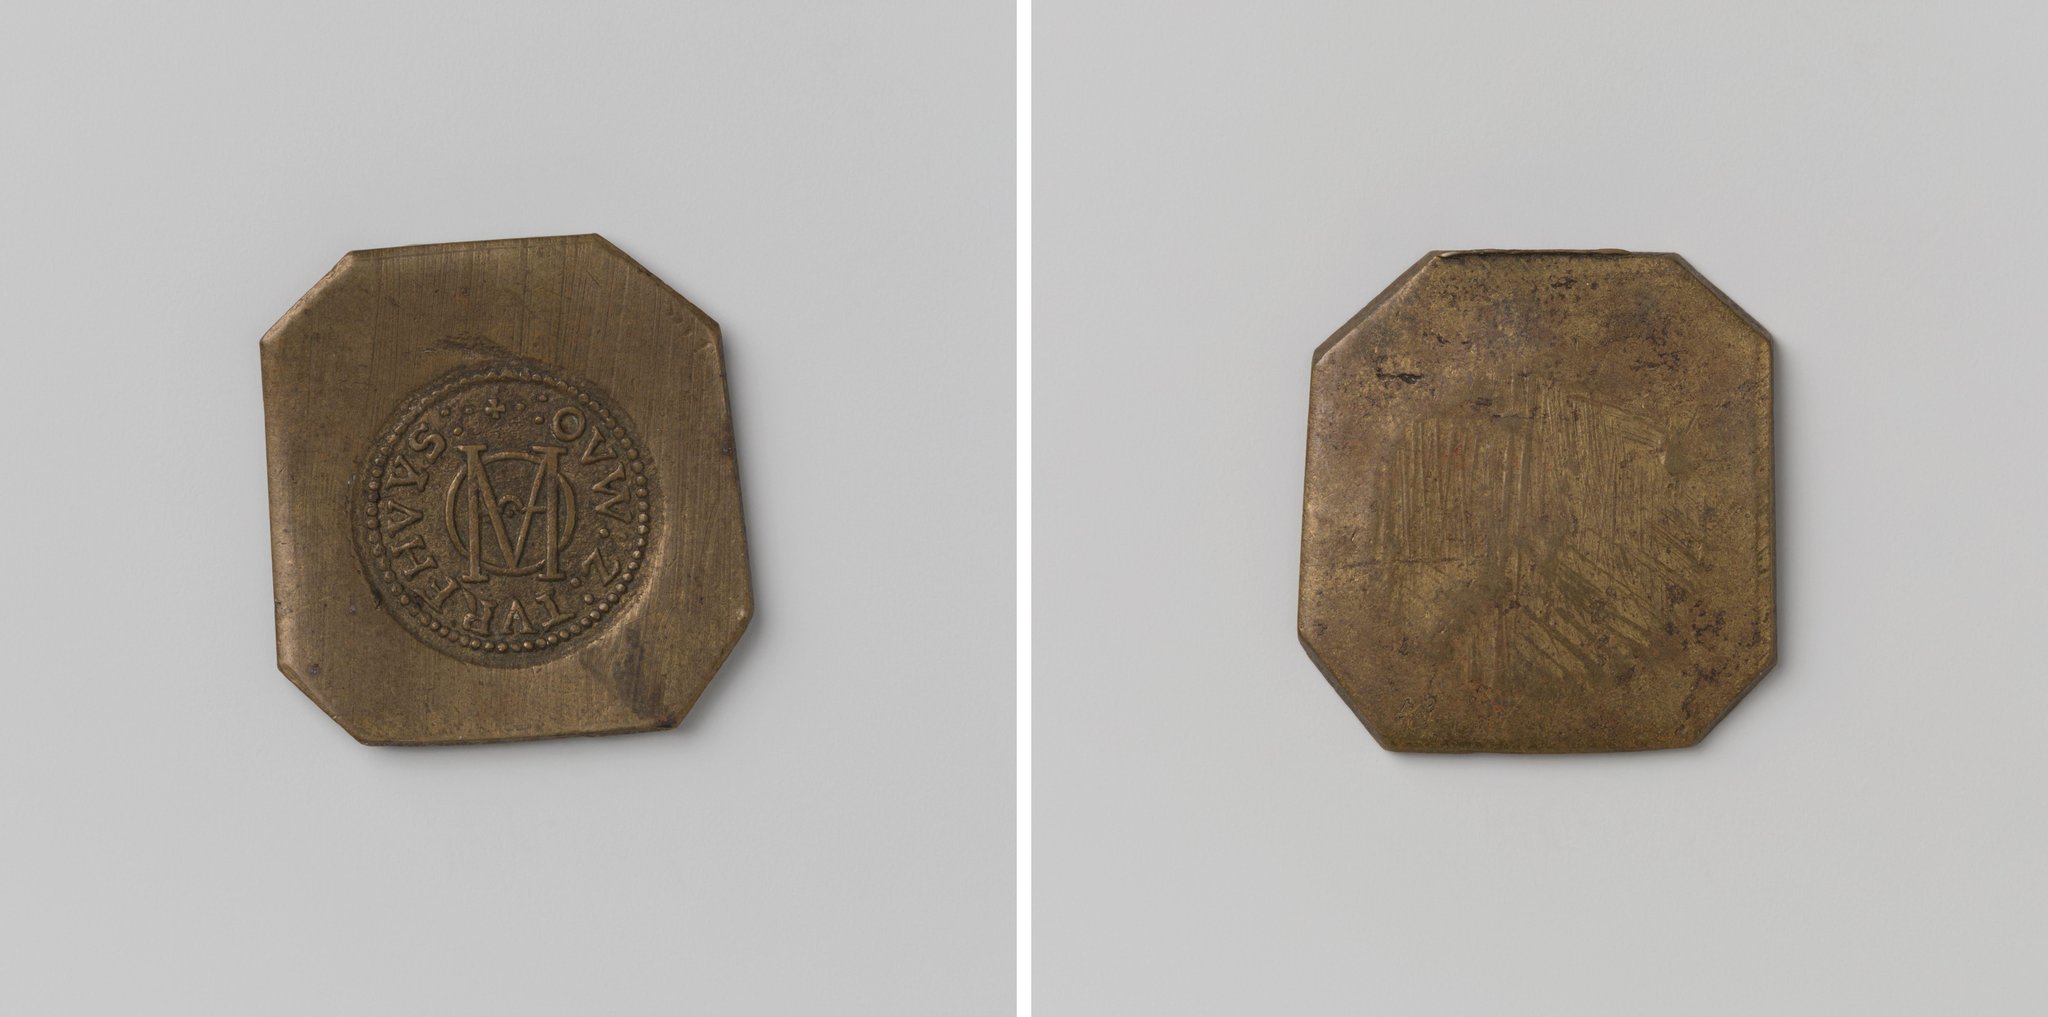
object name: turfloodje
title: Oudezijds Armhuis te Amsterdam, loodje dat bij uitdeling recht gaf op turf uit het turfhuis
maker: Anonymous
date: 1698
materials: brass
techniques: striking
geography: amsterdam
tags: amsterdam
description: Eenzijdig messing achthoekig armenloodje. Voorzijde: in ronde parelrand: monogram van letters O, A en H binnen omschrift. Keerzijde: blanco.